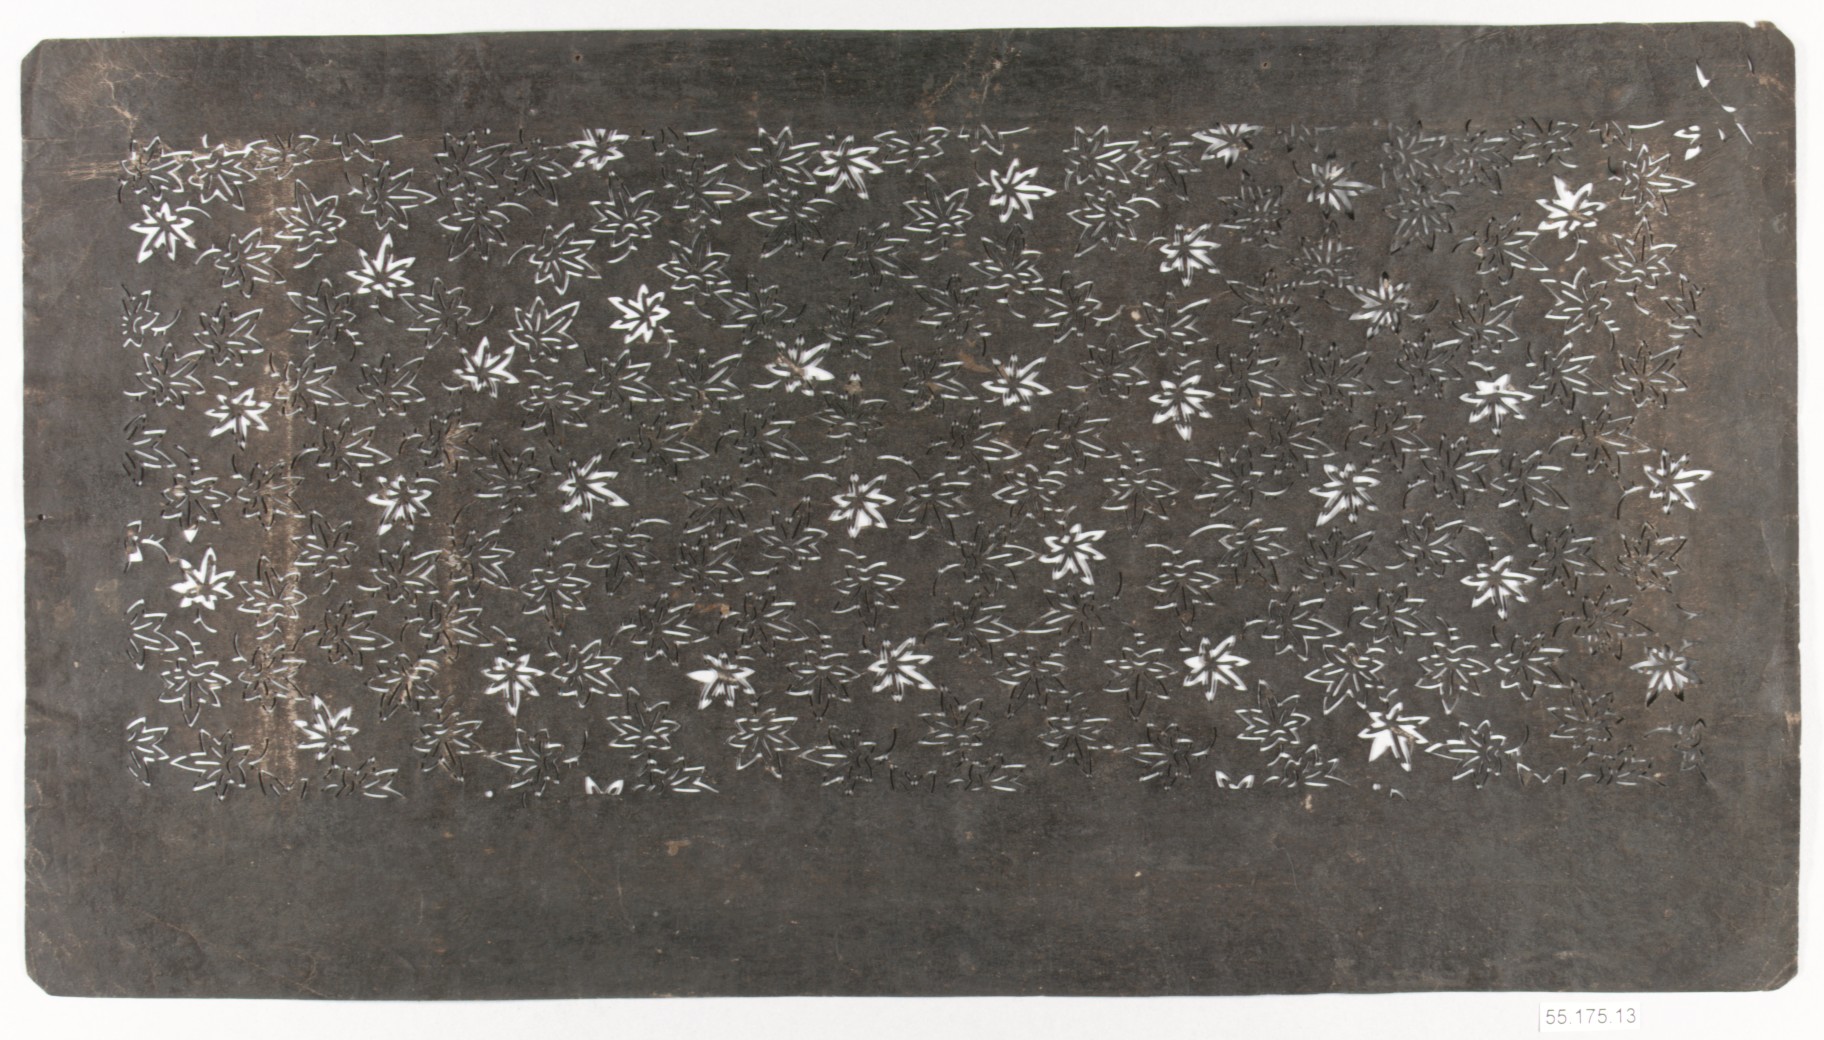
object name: stencil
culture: japanese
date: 1801-1900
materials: paper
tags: leaves